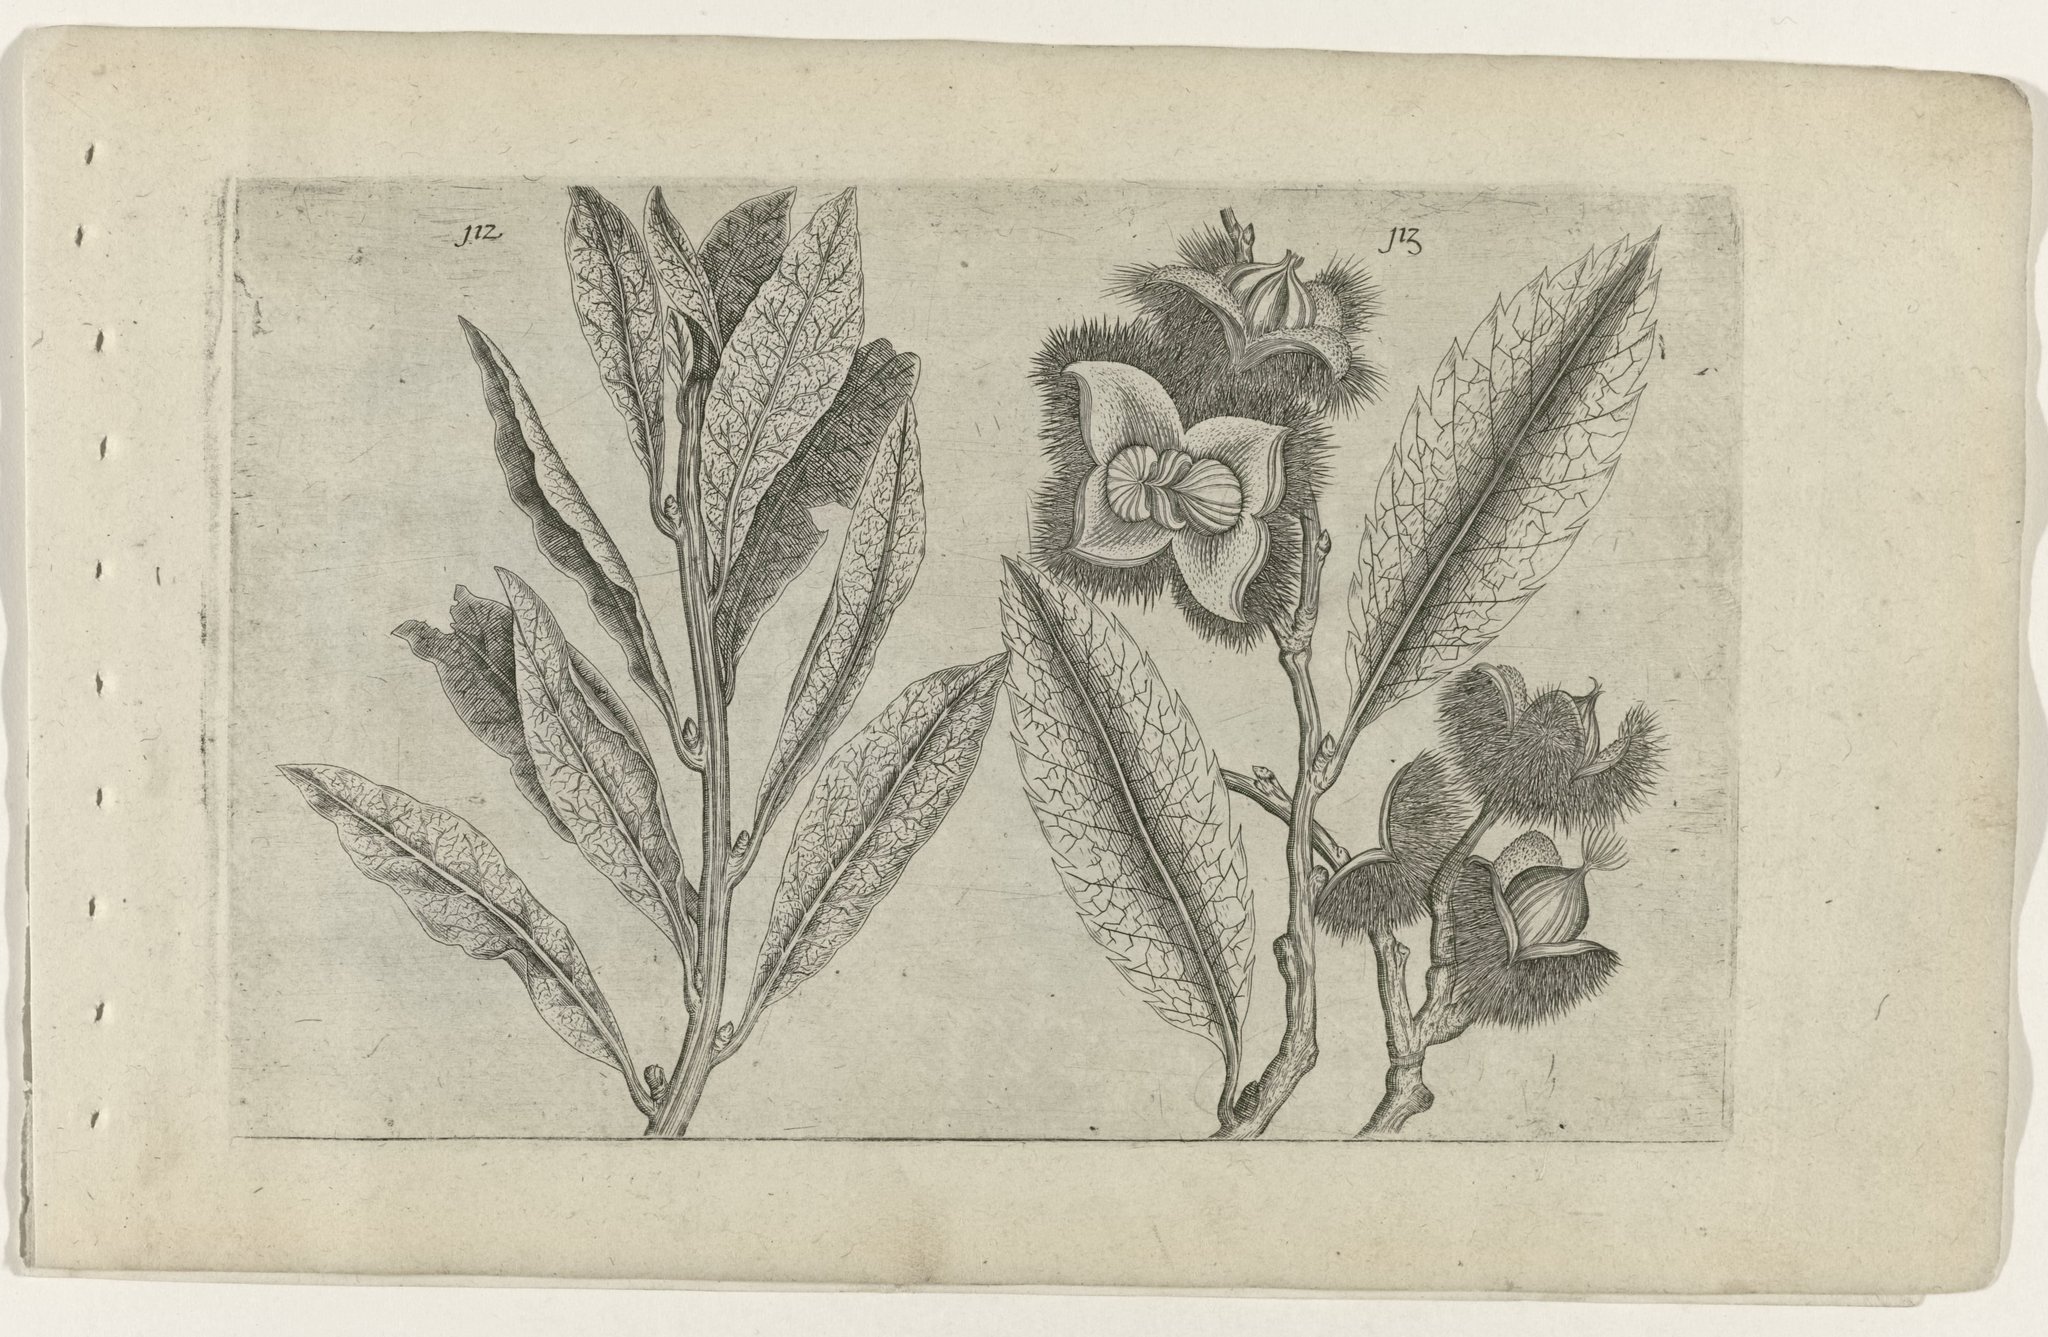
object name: album leaf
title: Salie en tamme kastanje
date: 1600-1604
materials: paper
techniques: engraving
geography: cologne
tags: fruits: chestnut, trees: willow, botany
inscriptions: collector's mark: Lugt 2228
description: De prenten RP-P-2012-24-1 t/m 61 waren oorspronkelijk als serie samengebonden. De naaigaten op de bladen zijn nog zichtbaar. Het betreft de reeks getiteld: Cognoscite lilia, bestaande uit een titelprent en 60 gravures met 119 genummerde weergaven van planten, bloemen en vruchten, versierd met rinceaux en kleine voorstellingen van dieren. Het gaat om proefdrukken van deze reeks gravures, voor de opschriften en, deels, voor de nummering. Op enkele prenten zijn de nummers met de hand aangebracht. Op de titelprent ontbreekt nog het adres van Crispijn de Passe en Hans Woutneel. De titel is hoogstwaarschijnlijk gegraveerd door Matthias Quad. Deze werkte voor De Passe in Keulen tot 1604. De reeks moet in dit jaar of daarvoor tot stand zijn gebracht. In ieder geval voor 1608, aangezien de uitgever Hans Woutneel in of voor dat jaar overleed. In ieder geval voor 1608, aangezien de uitgever Hans Woutneel in of voor dat jaar overleed. De gravures worden door Ilja Veldman en Anthony Griffiths beschouwd als eigenhandig werk van Crispijn de Passe I. Een van de prenten uit de reeks ontbreekt (nr 21-22) en is vervangen door een ingekleurde afdruk uit een latere uitgave (RP-P-2012-24-61), die onder de titel Altera Pars is opgenomen in de Hortus Floridus, uitgegeven door Crispijn de Passe I en die verder bestaat uit platen van Crispijn de Passe II. De prenten afkomstig uit deze uitgave zijn op de verso voorzien van tekst in boekdruk. De vervangende prent maakte geen deel uit van de gebonden serie aangezien dit blad als enige geen naaigaten heeft. Een deel van de planten, bloemen en vruchten in de Cognoscite lilia gaat terug of is gebaseerd op een reeks aquarellen van Jacques LeMoyne uit circa 1580 en uit 1585, nu in het Victoria and Albert Museum en de British Museum (zie P. Hulton, Jacques LeMoyne, Londen 1977, dl 1, p. 156-162 en p. 165-173).